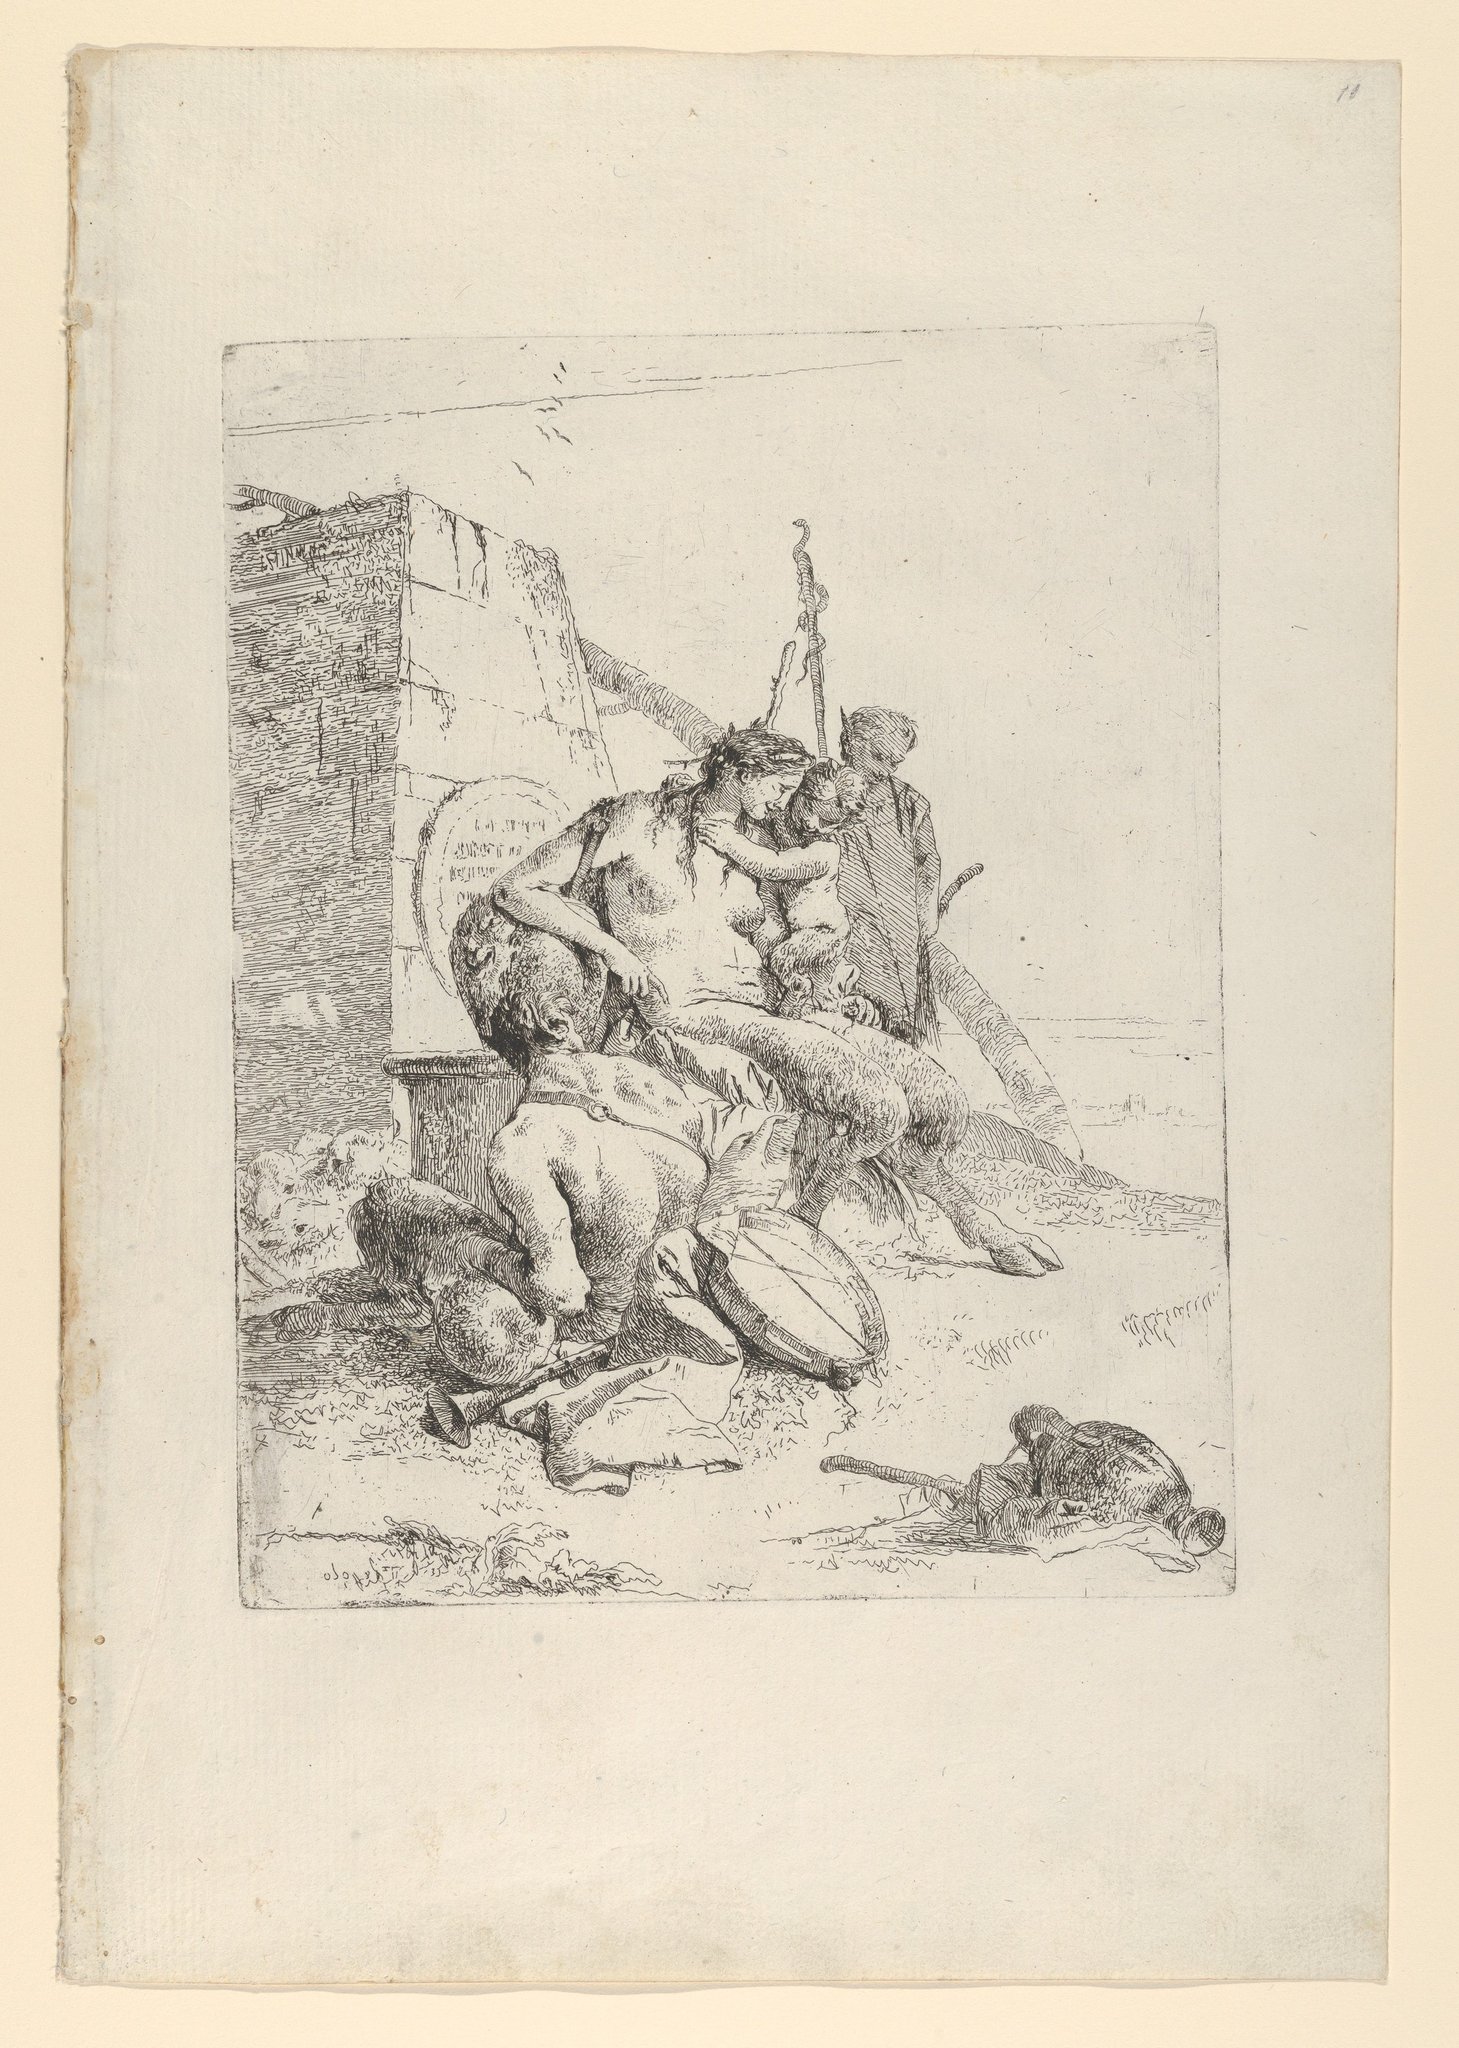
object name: print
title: Satyr Family with the Obelisk, from the Scherzi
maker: giovanni battista tiepolo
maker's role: artist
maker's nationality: italian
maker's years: 1696-1770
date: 1743-1750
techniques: etching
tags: obelisks,infants,female nudes,satyrs